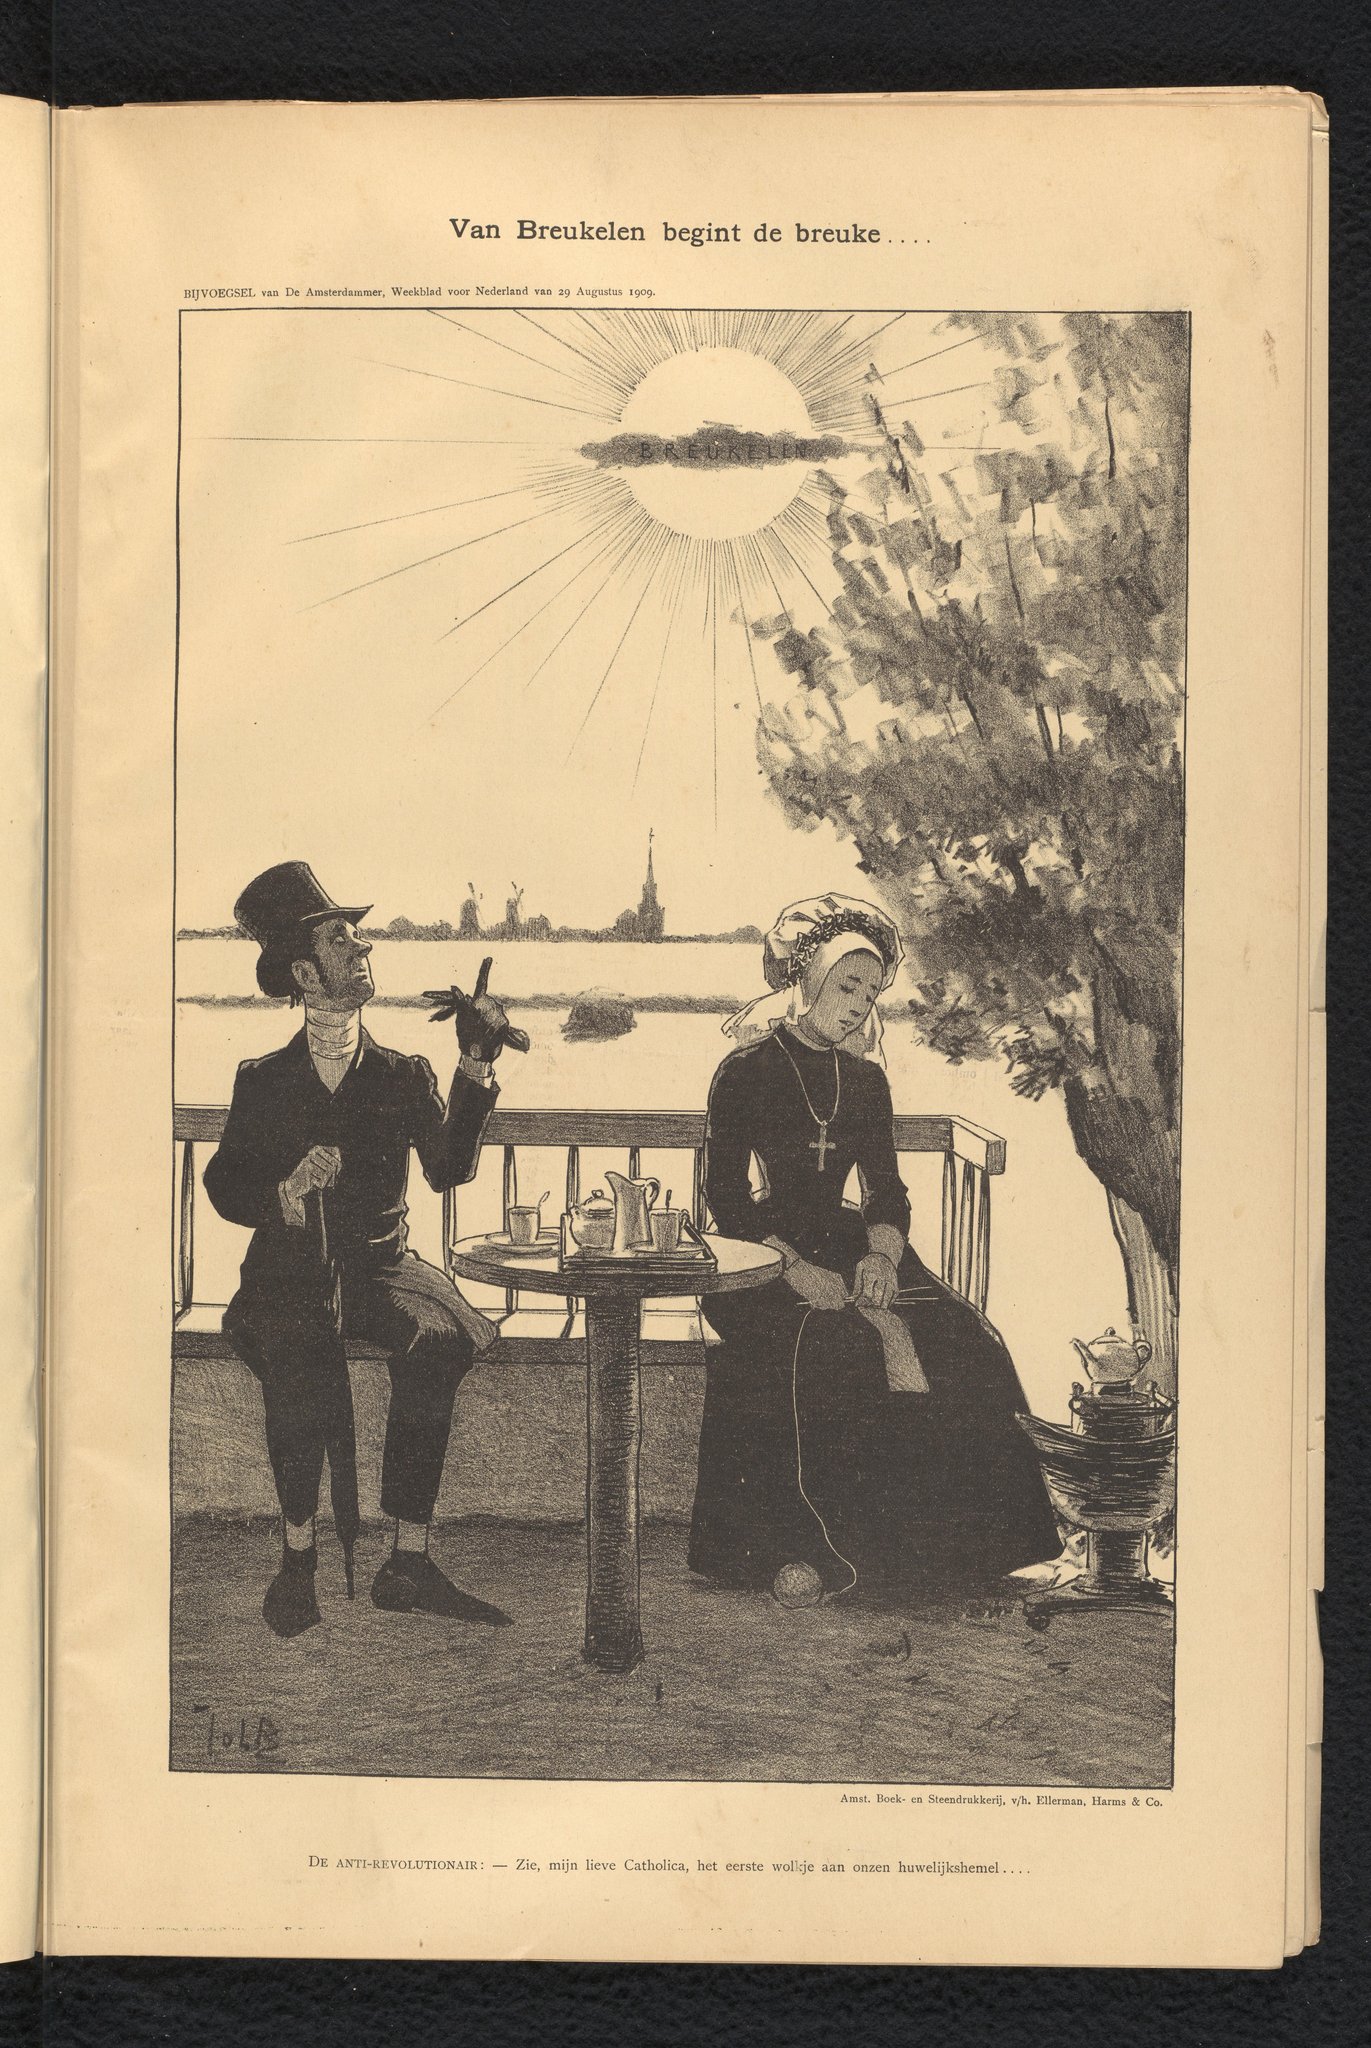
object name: cartoon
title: Van Breukelen begint de breuke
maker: johan braakensiek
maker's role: draughtsman, print maker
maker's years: 1858-1940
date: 1909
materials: paper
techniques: lithograph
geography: amsterdam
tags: marriage, married couple, 'matrimonium', political parties, political caricatures and satires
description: Verkoeling in de relatie tussen de antirevolutionairen en katholieken bij de tussentijdse verkiezing in Breukelen voor de Tweede Kamerlid, na de benoeming van De Waal Malefijt tot minister. De politieke partijen voorgesteld als een echtpaar buiten aan de thee.